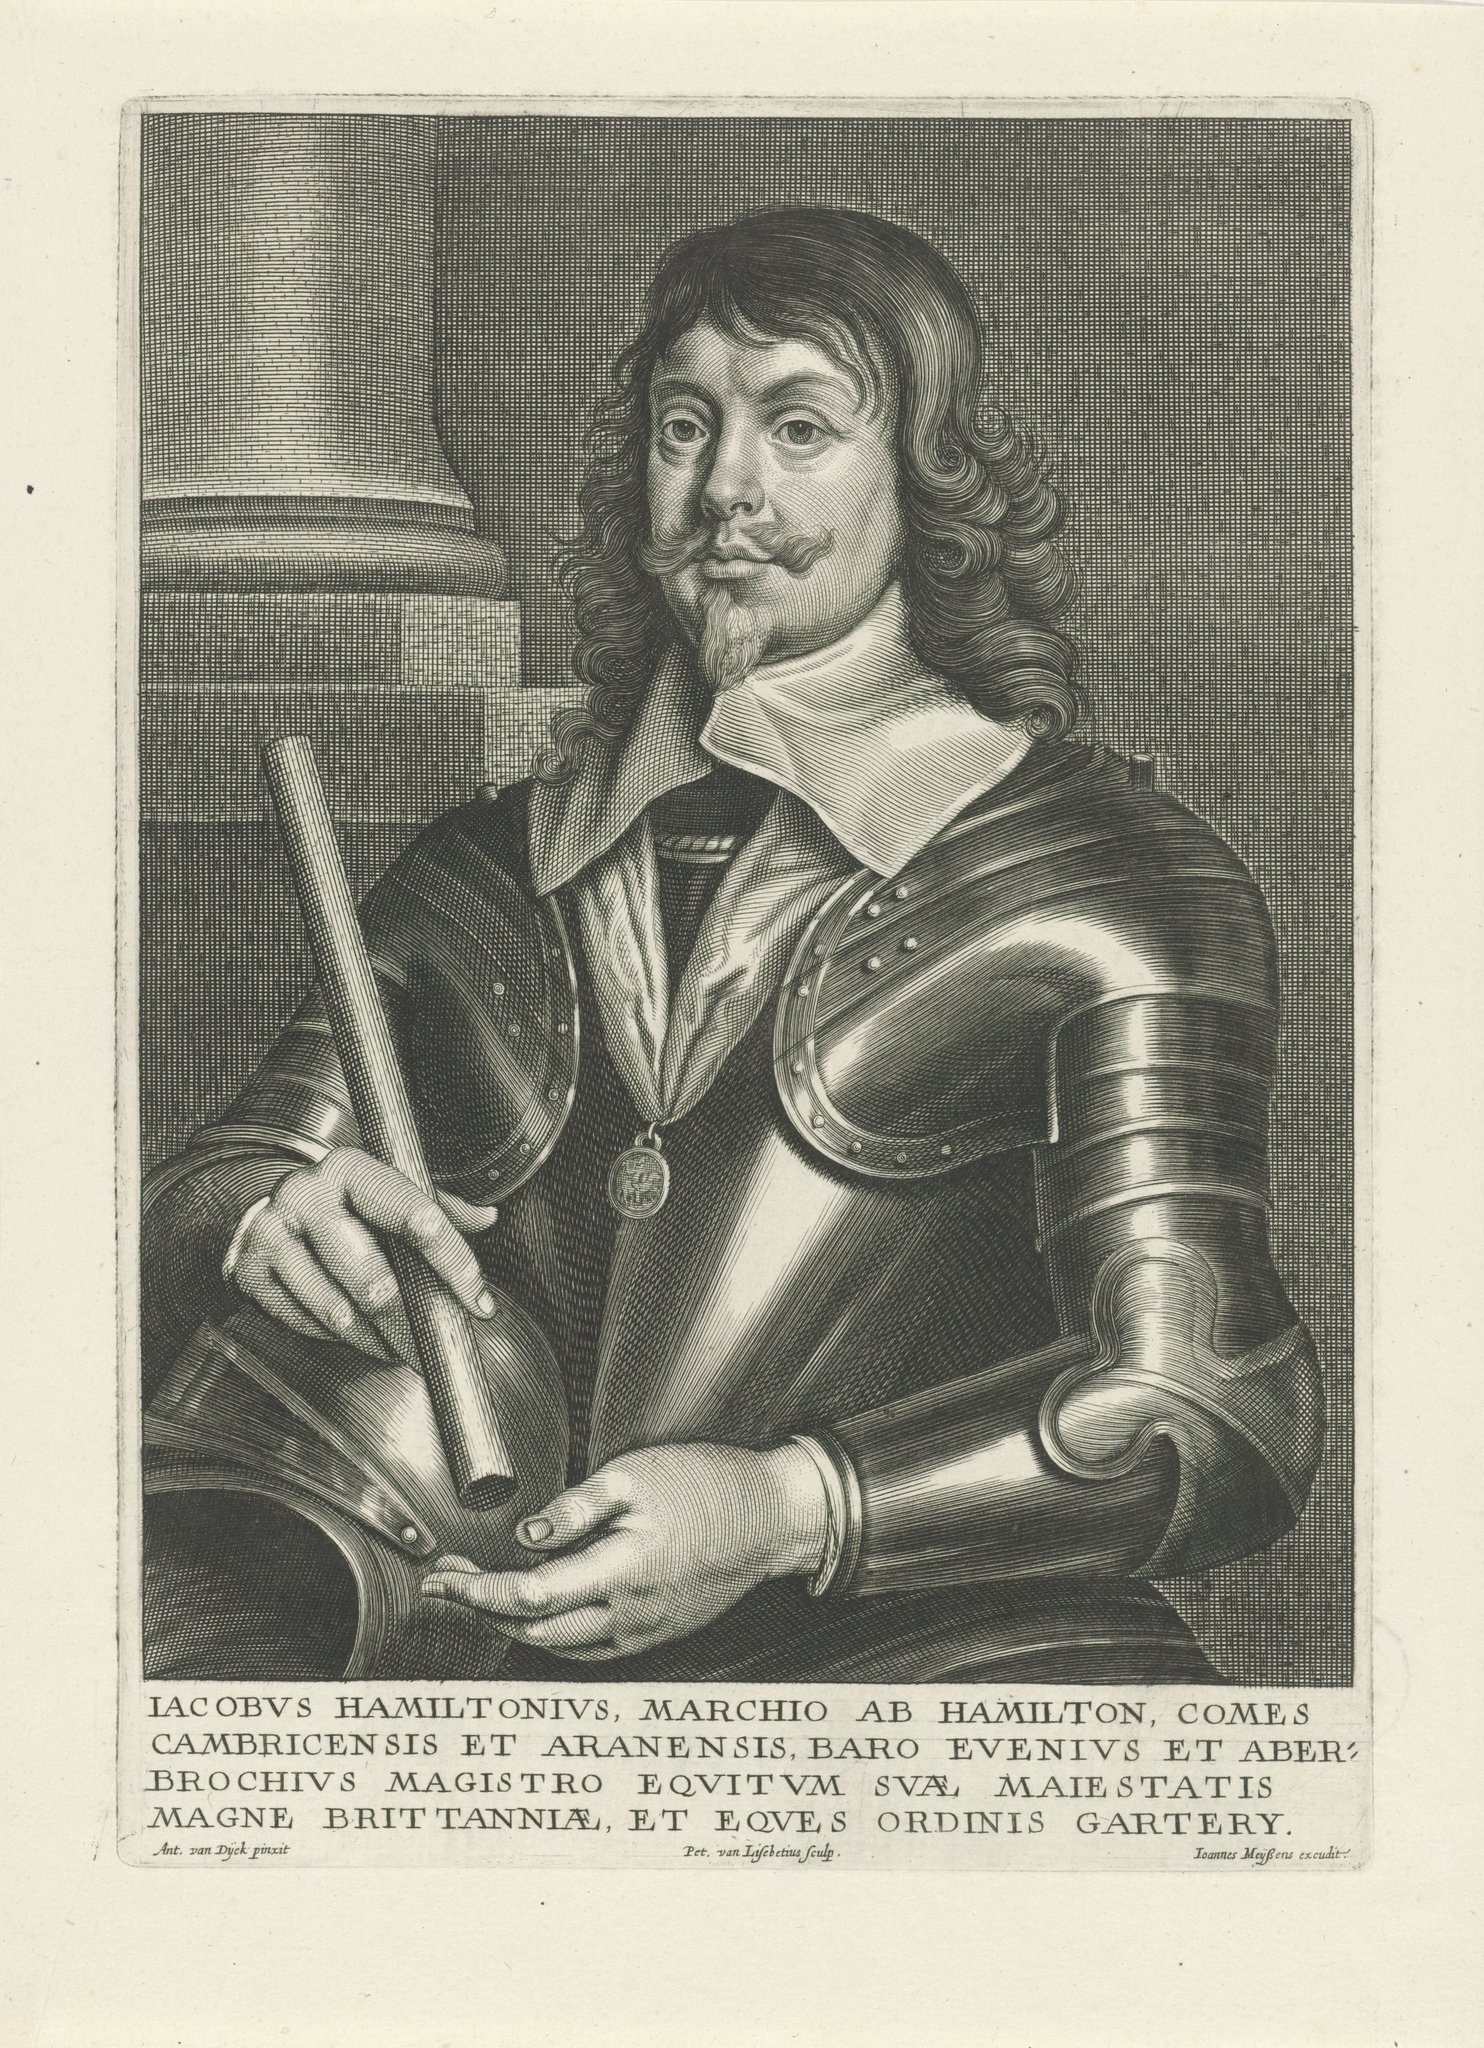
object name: print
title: Portret van James Hamilton, eerste hertog van Hamilton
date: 1640-1670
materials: paper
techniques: engraving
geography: antwerp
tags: james i hamilton (hertog van hamilton)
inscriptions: collector's mark: Lugt 240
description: James Hamilton, graaf van Aran en eerste hertog van Hamilton. Generaal van het Schotse leger tijdens de Engelse burgeroorlog.